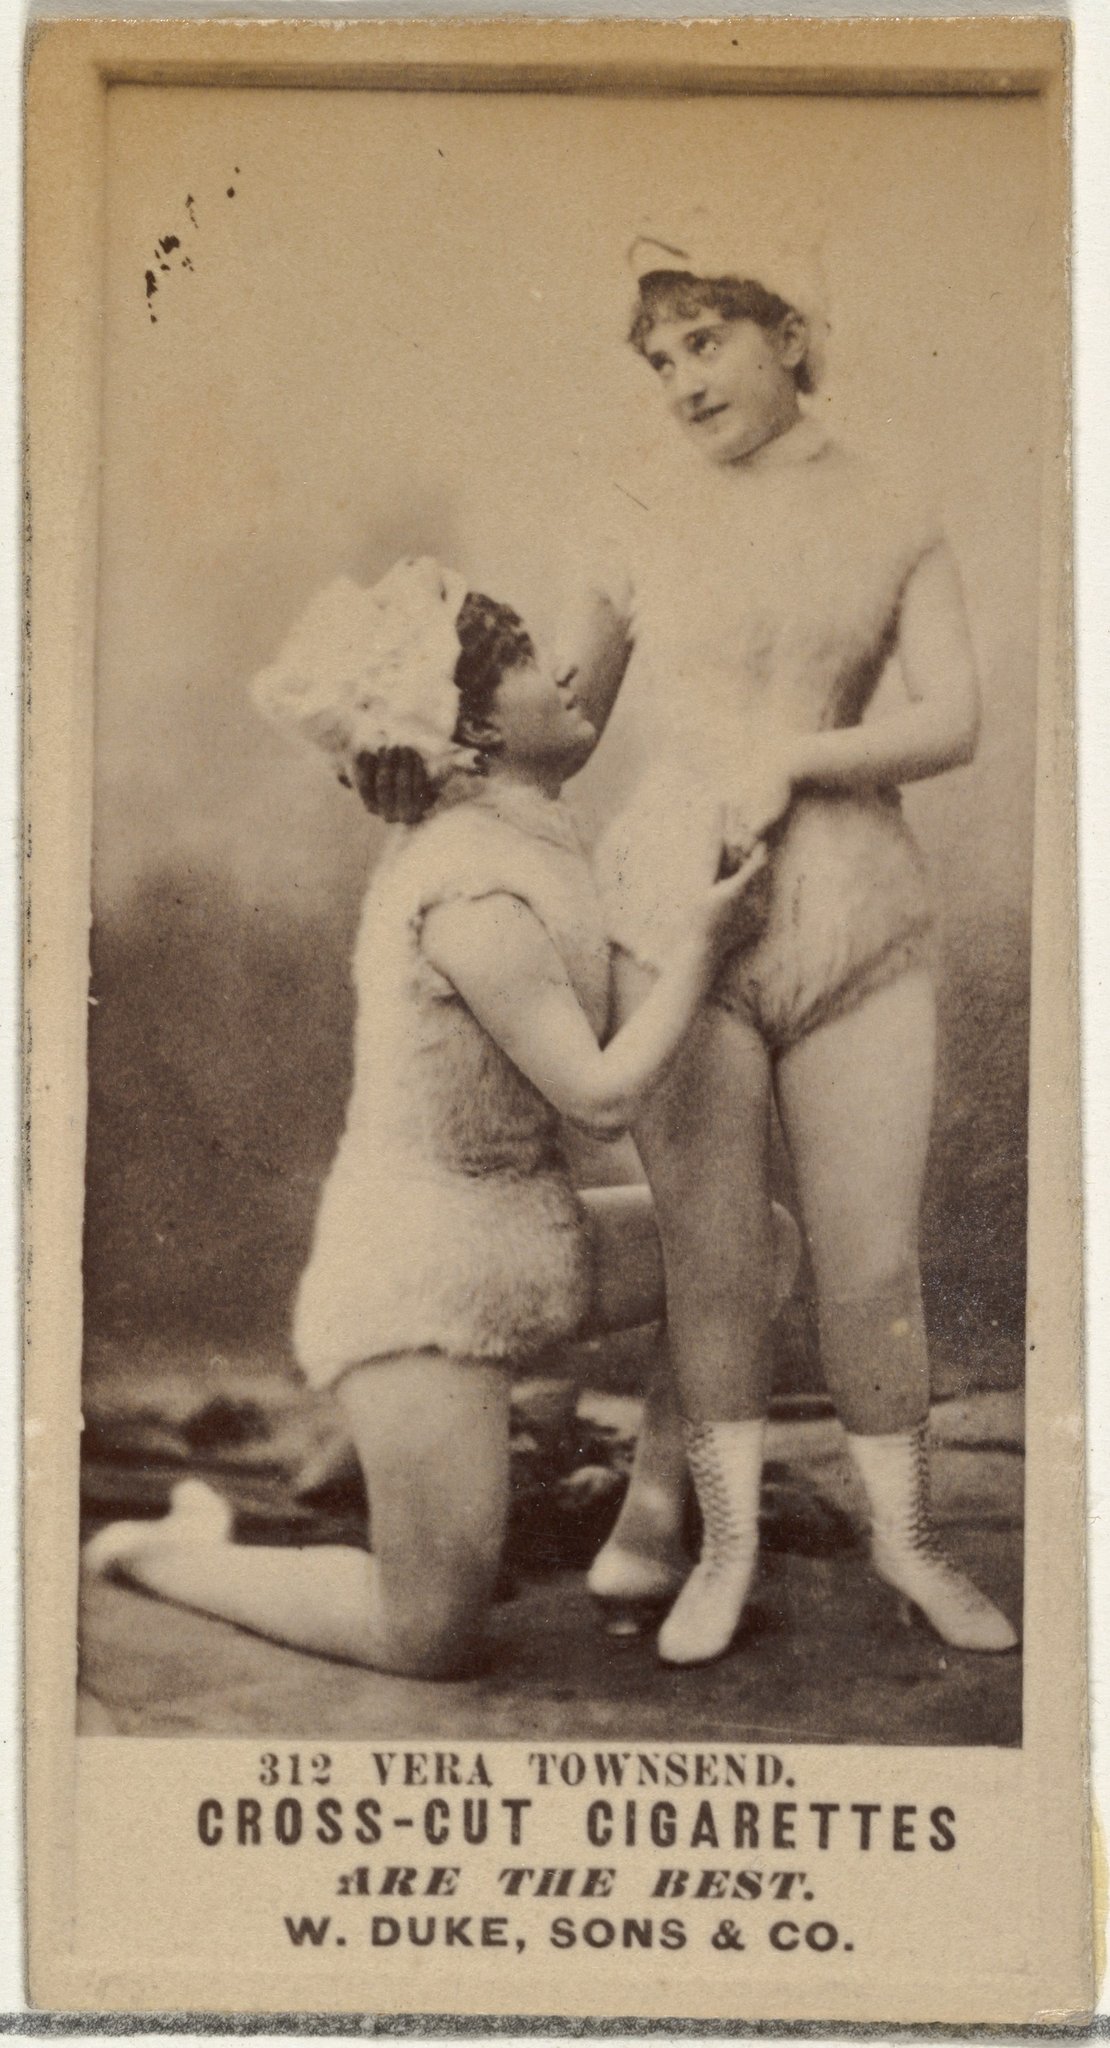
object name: photograph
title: Card Number 312, Vera Townsend, from the Actors and Actresses series (N145-3) issued by Duke Sons & Co. to promote Cross Cut Cigarettes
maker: w. duke, sons & co.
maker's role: publisher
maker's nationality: american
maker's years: 1870-1920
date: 1880-1889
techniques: albumen silver print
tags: portraits,women,actresses